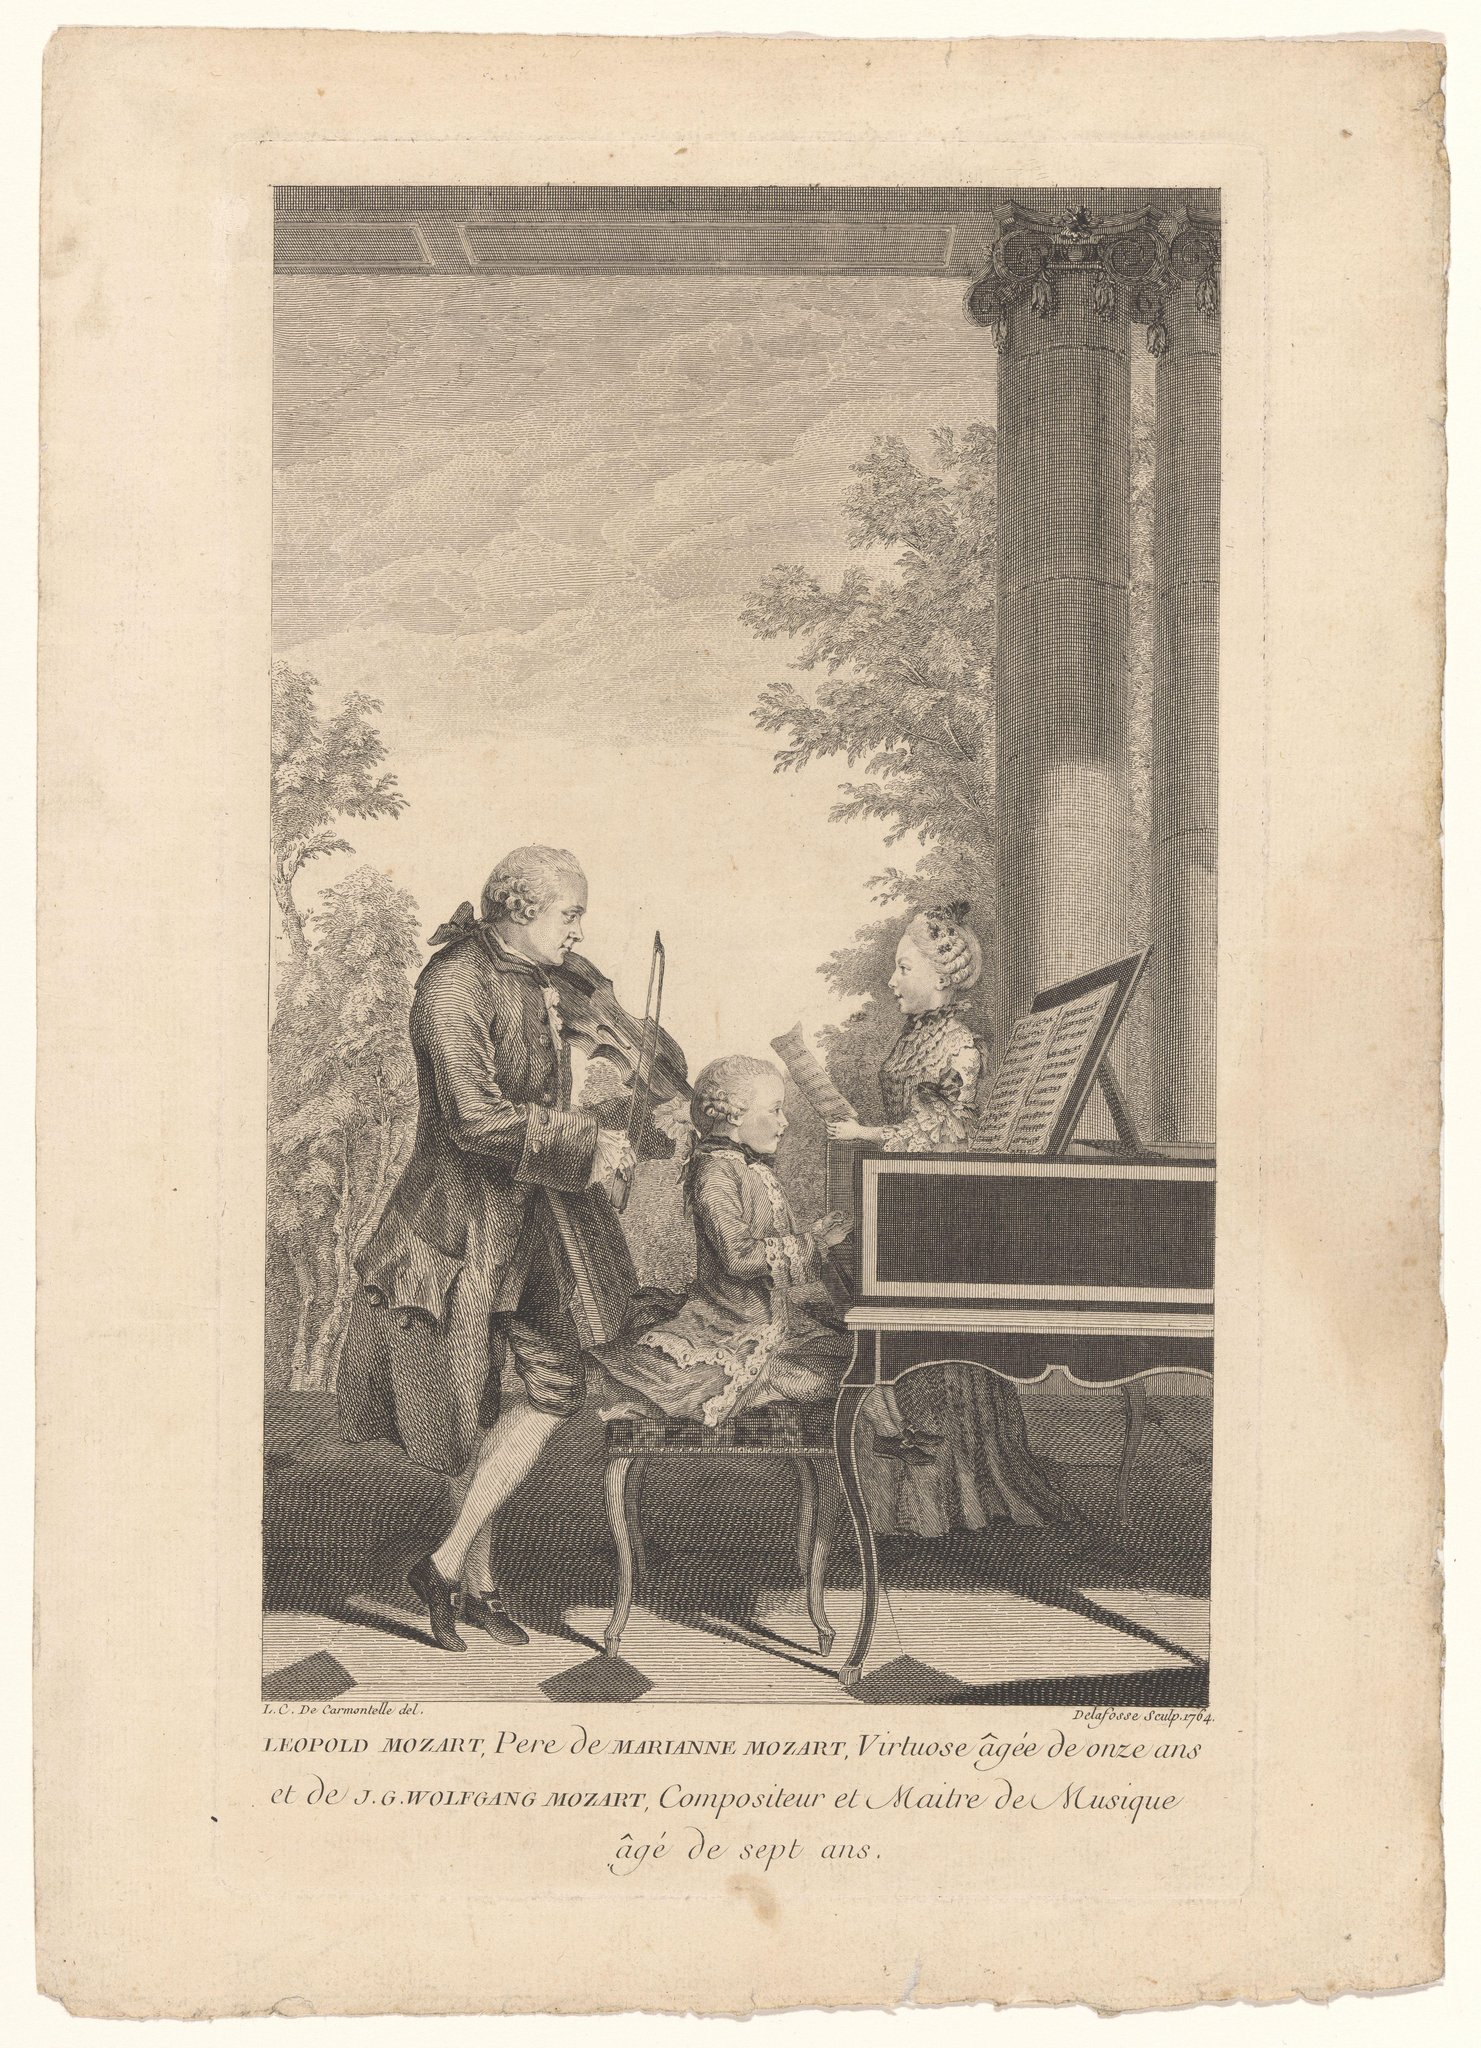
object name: print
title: Leopold Mozart, Pere de Marianne Mozart, Virtuose âgée de onze ans et de J. G. Wolfgang Mozart, Compositeur et Maitre de Musique âgé de sept ans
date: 1764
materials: paper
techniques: engraving, etching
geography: paris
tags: vienna, augsburg, instrumental and vocal music together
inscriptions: collector's mark: Lugt 2228, collector's mark: Lugt 2760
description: Muziekuitvoering van Leopold Mozart op viool, met zang van zijn elfjarige dochter Marianne Mozart en zijn zevenjarige zoon Wolfgang Amadeus Mozart op klavecimbel.